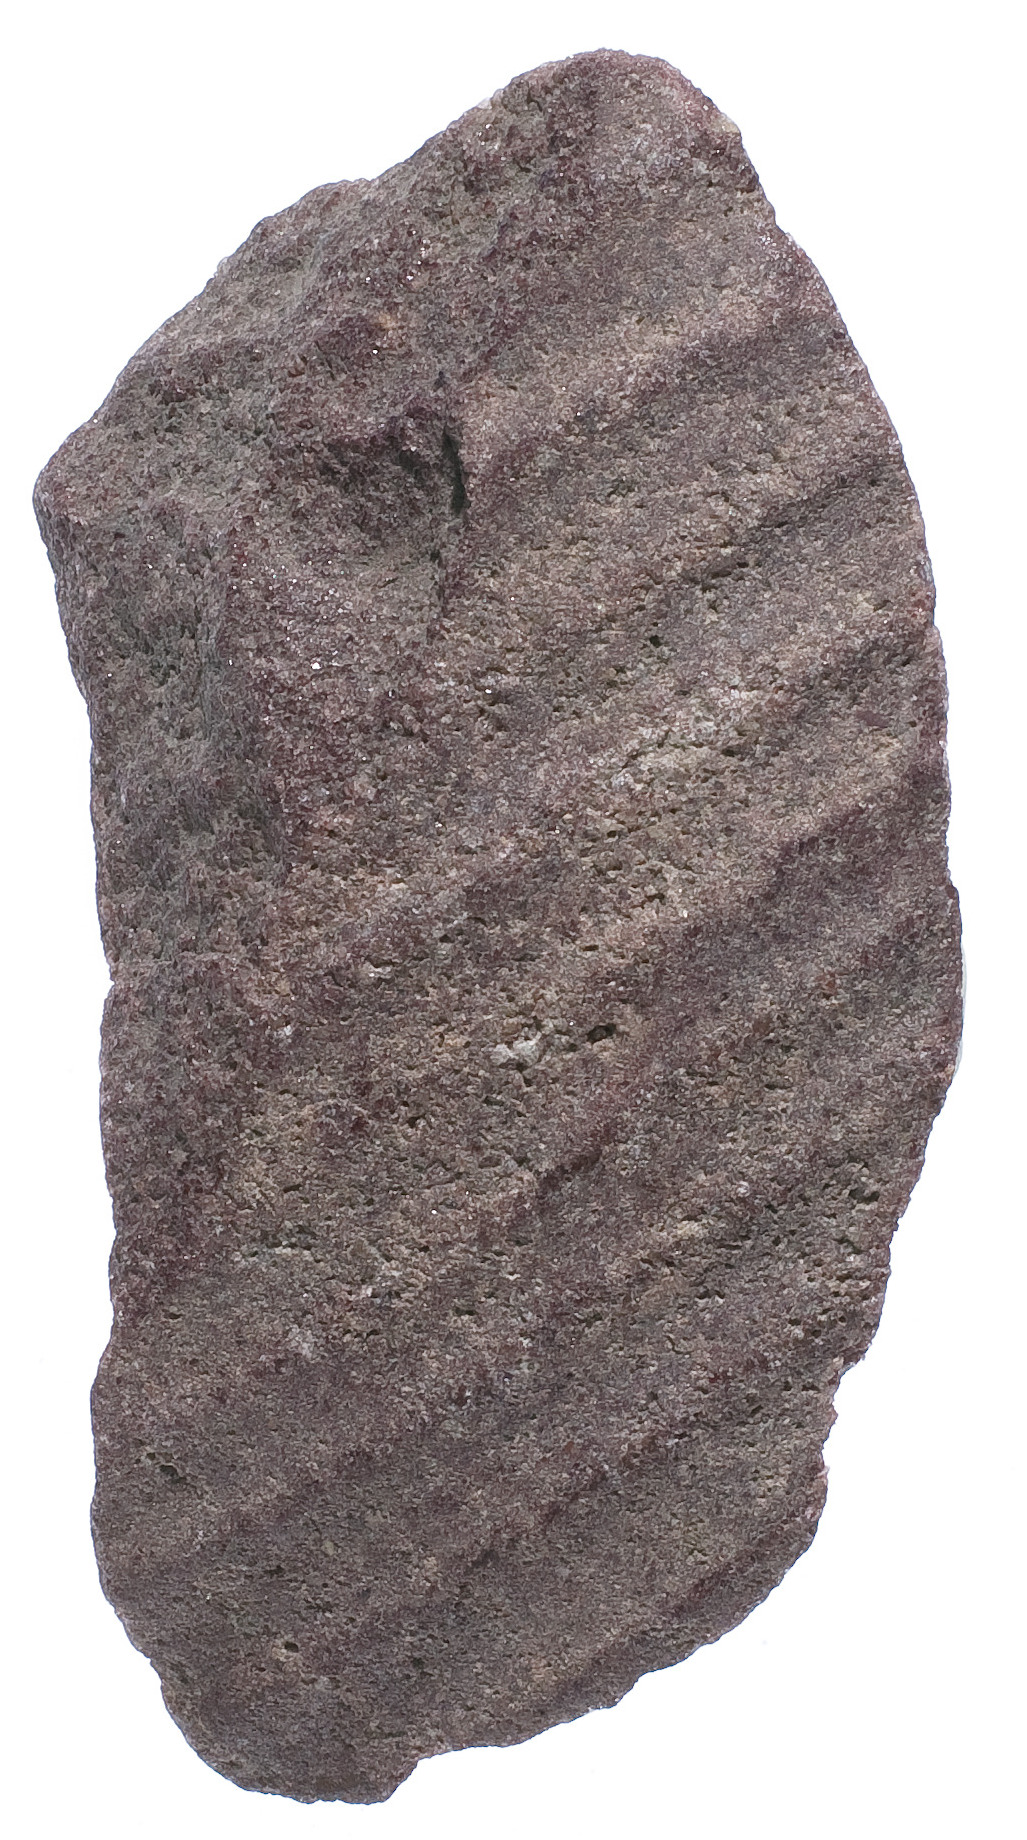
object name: body with garment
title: body with garment pleats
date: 1353-1336 BCE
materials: quartzite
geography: egypt